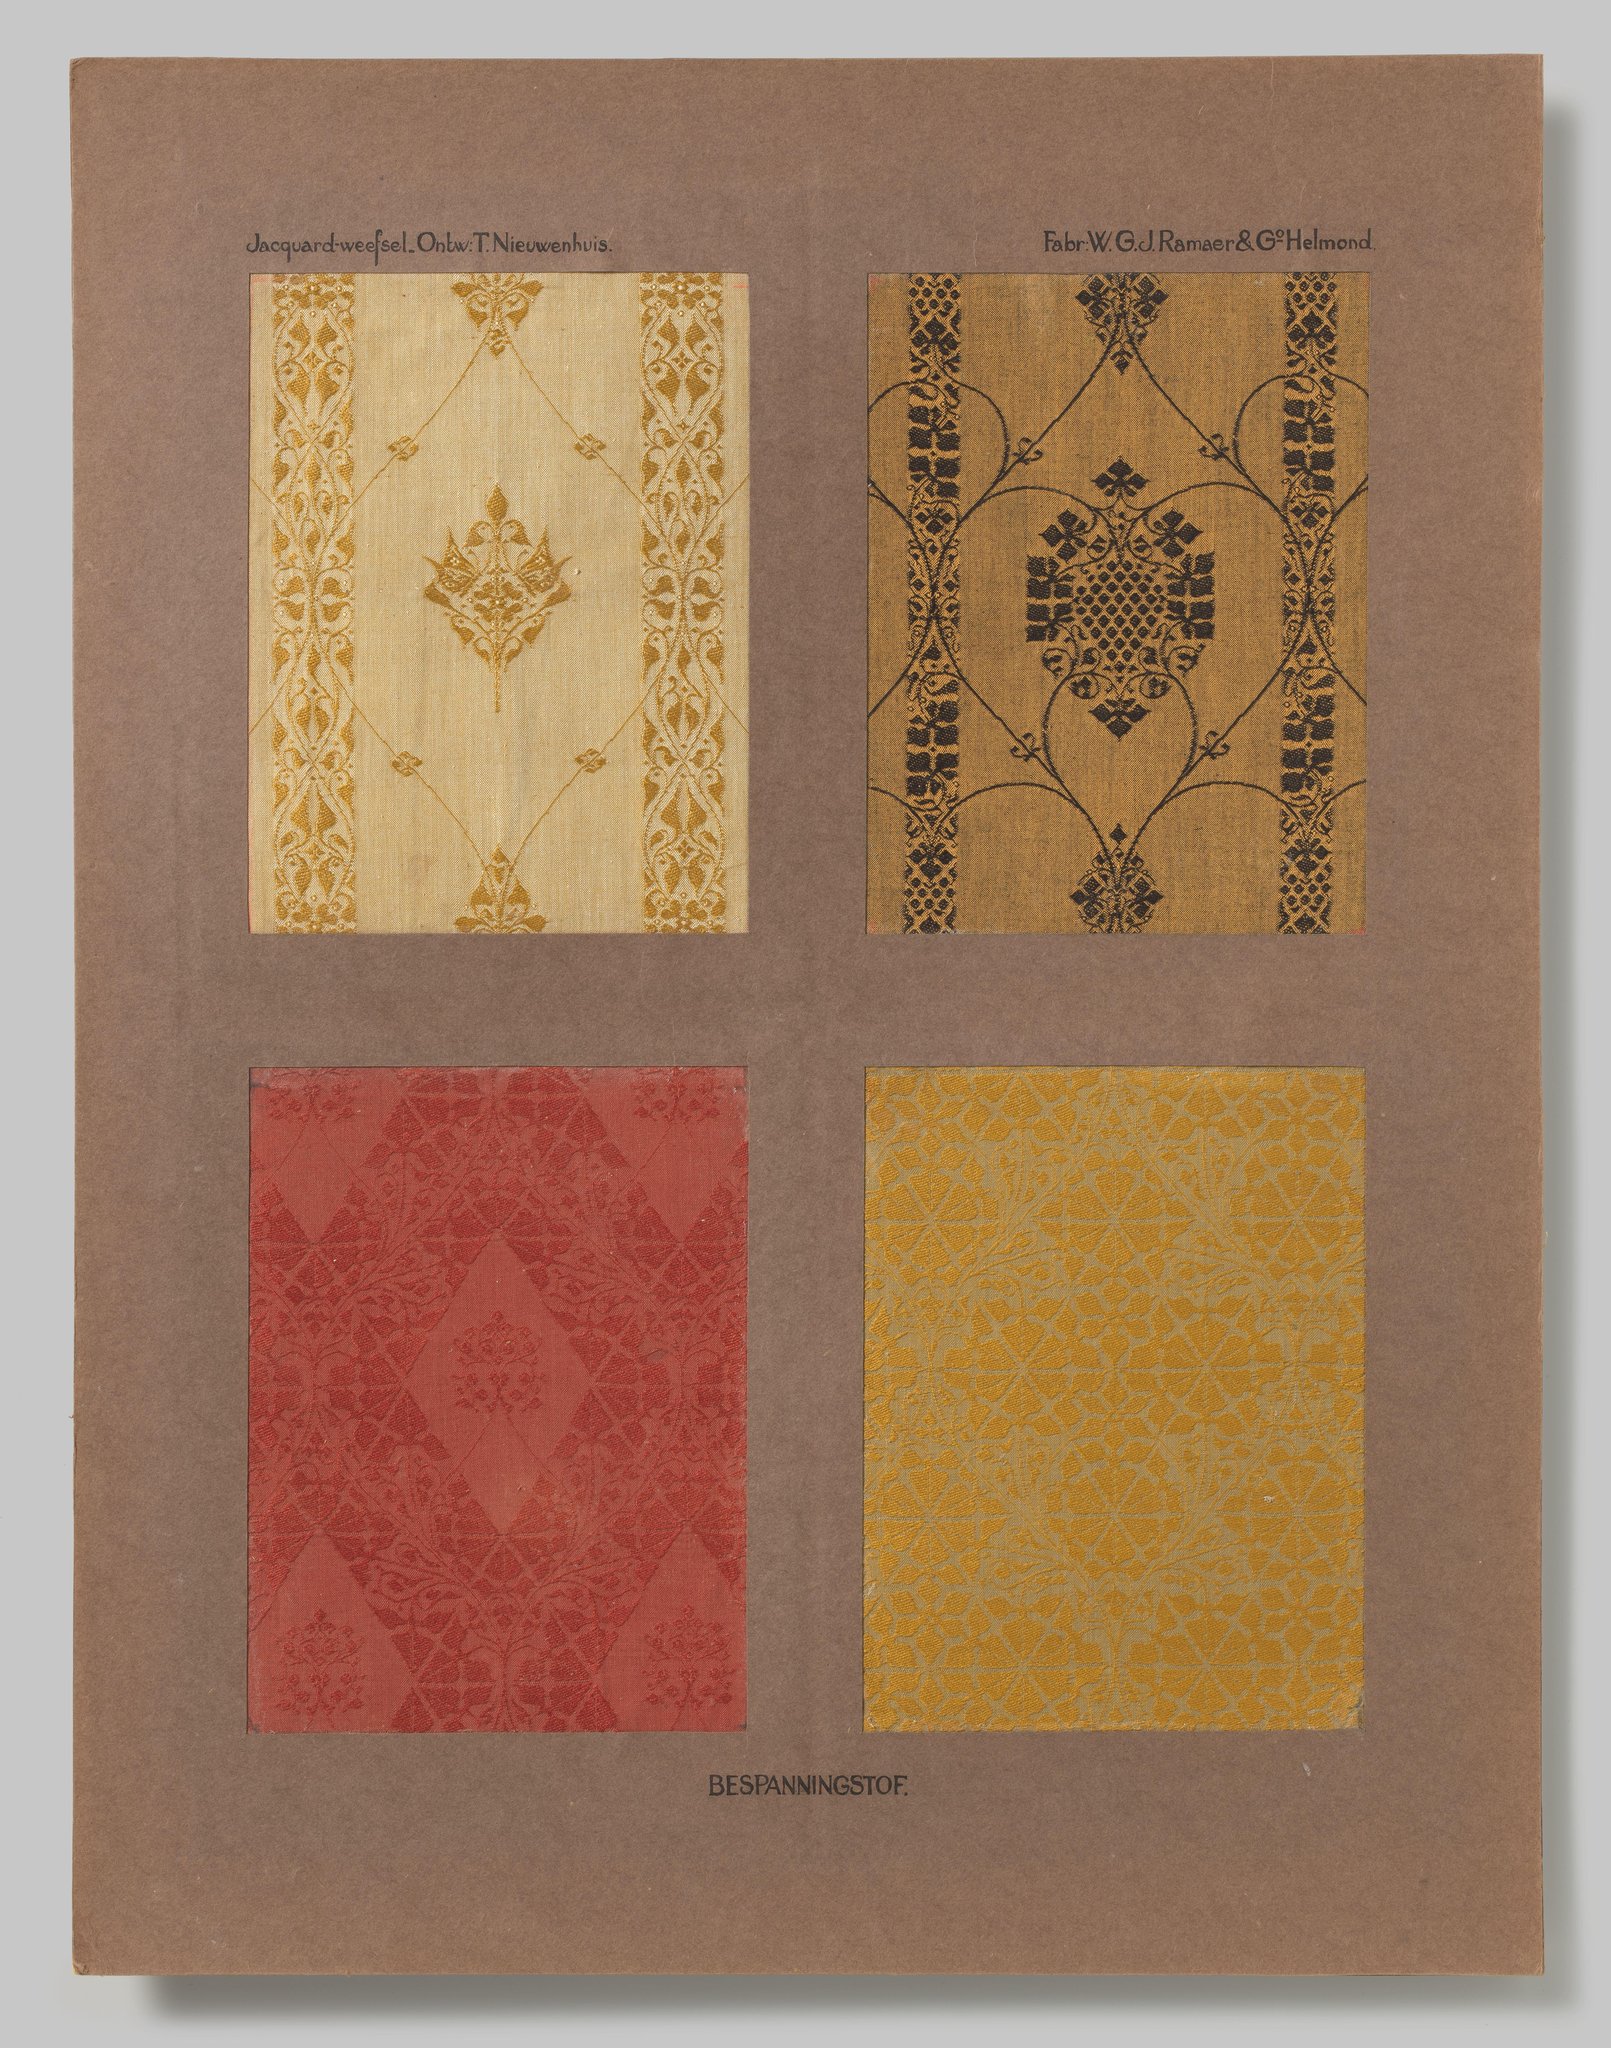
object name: upholstery fabric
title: Stalen bespanningsstof naar ontwerp van Theo Nieuwenhuis in passe-partout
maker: theo nieuwenhuis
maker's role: designer, draughtsman, print maker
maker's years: 1866-1951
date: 1909-1924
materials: cardboard, cotton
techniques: jacquard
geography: netherlands